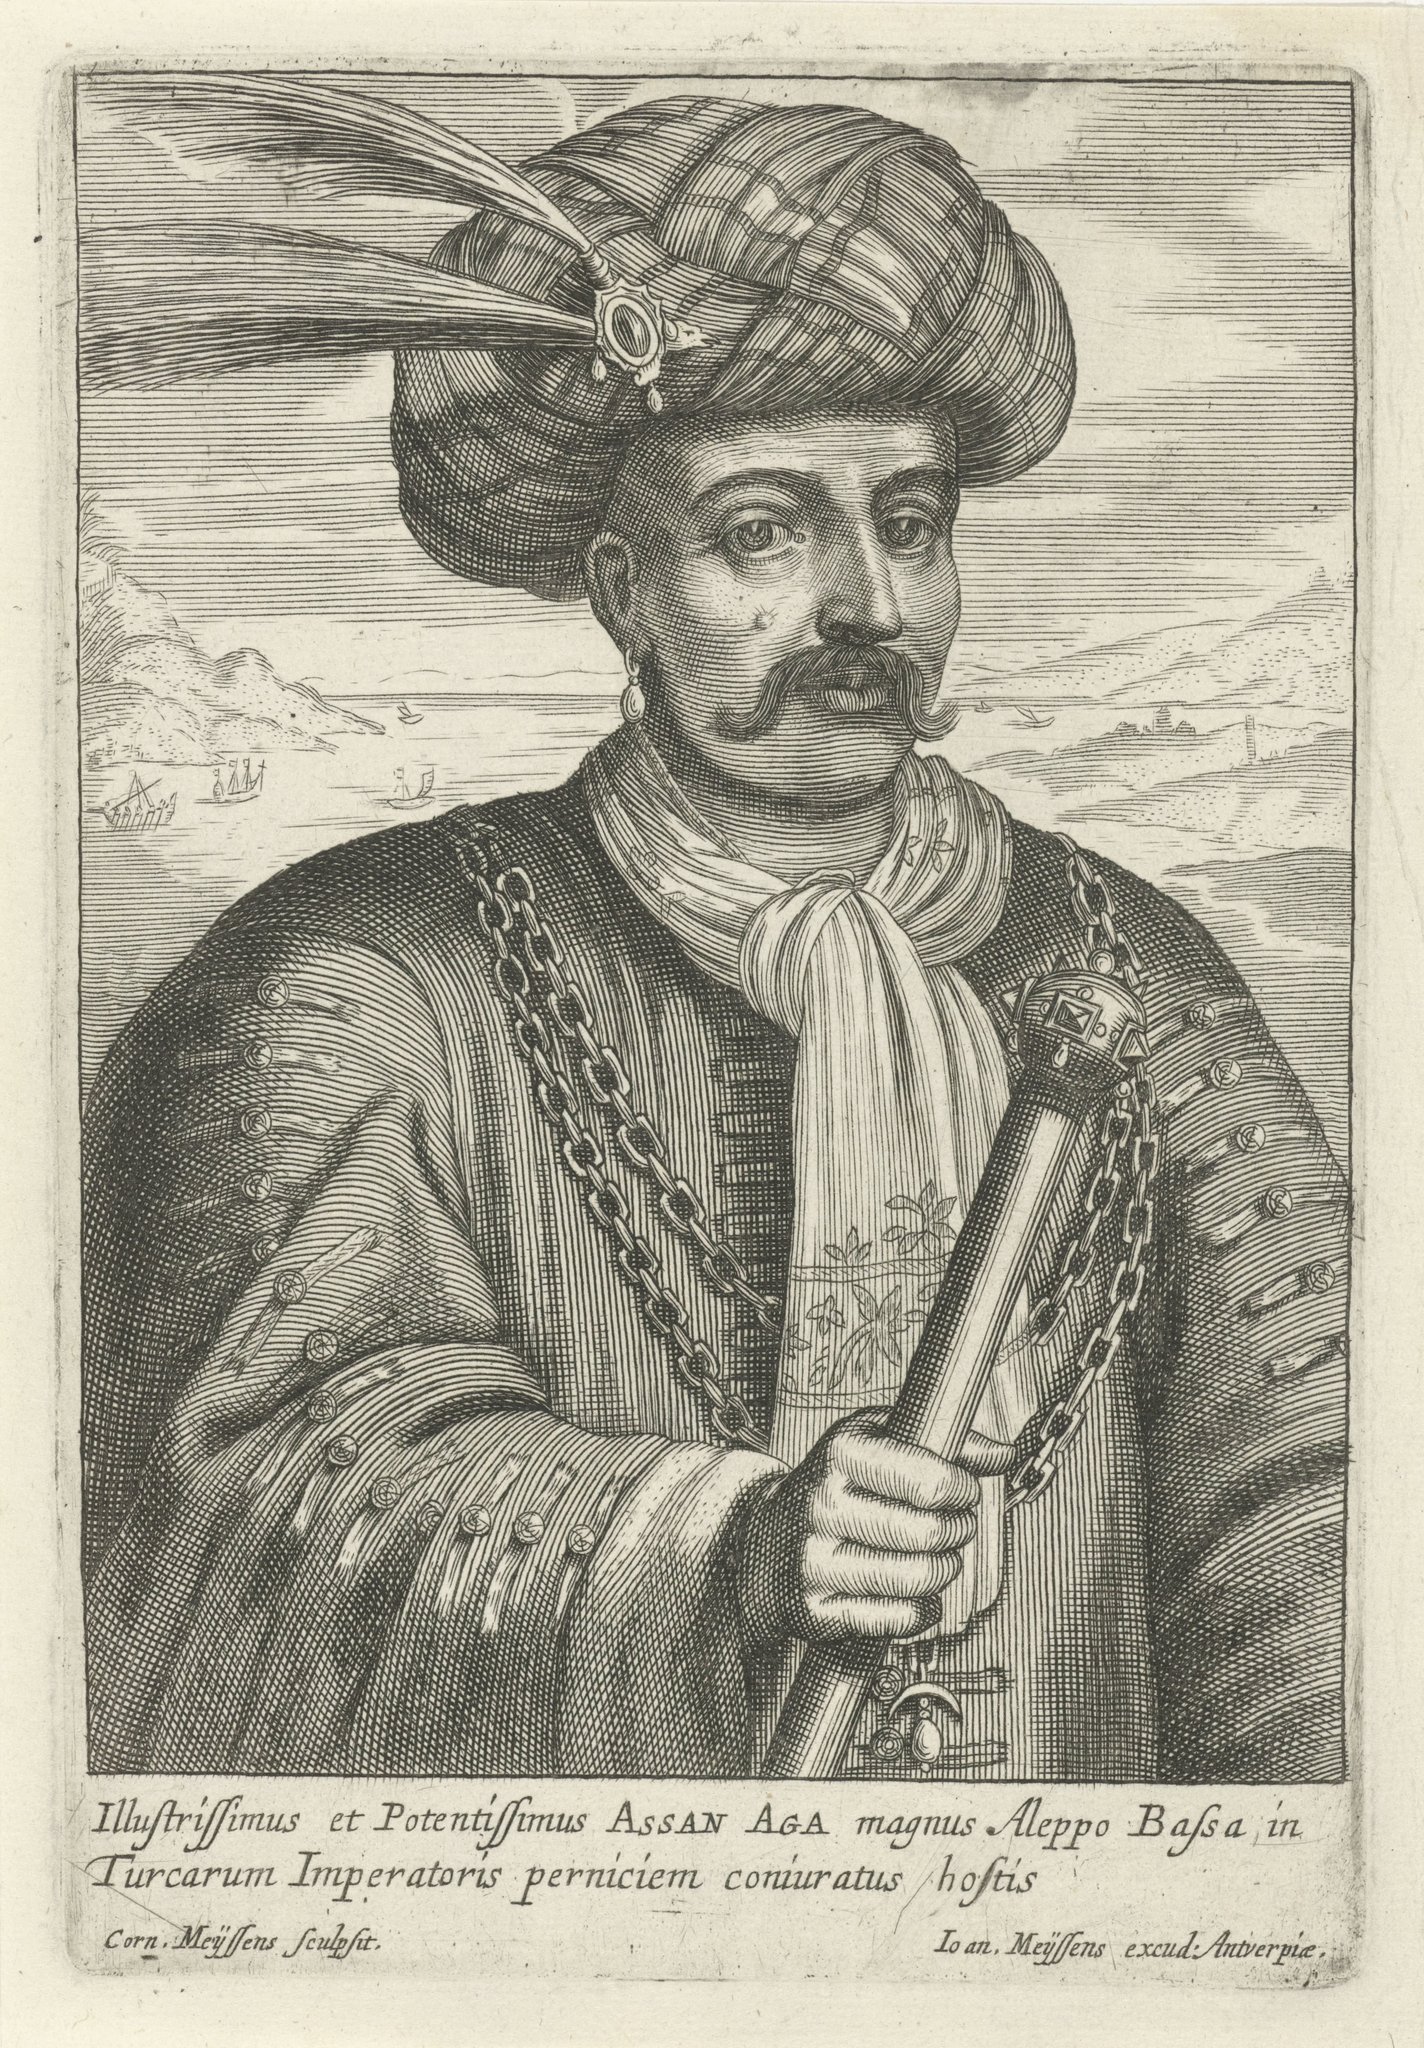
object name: print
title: Portret van Assan Aga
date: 1650-1670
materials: paper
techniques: engraving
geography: antwerp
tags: assan aga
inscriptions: collector's mark: Lugt 2228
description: Portret van Assan Aga, vermoedelijk een Ottomaanse vorst. In zijn hand een scepter. Op de achtergrond een baai met schepen.